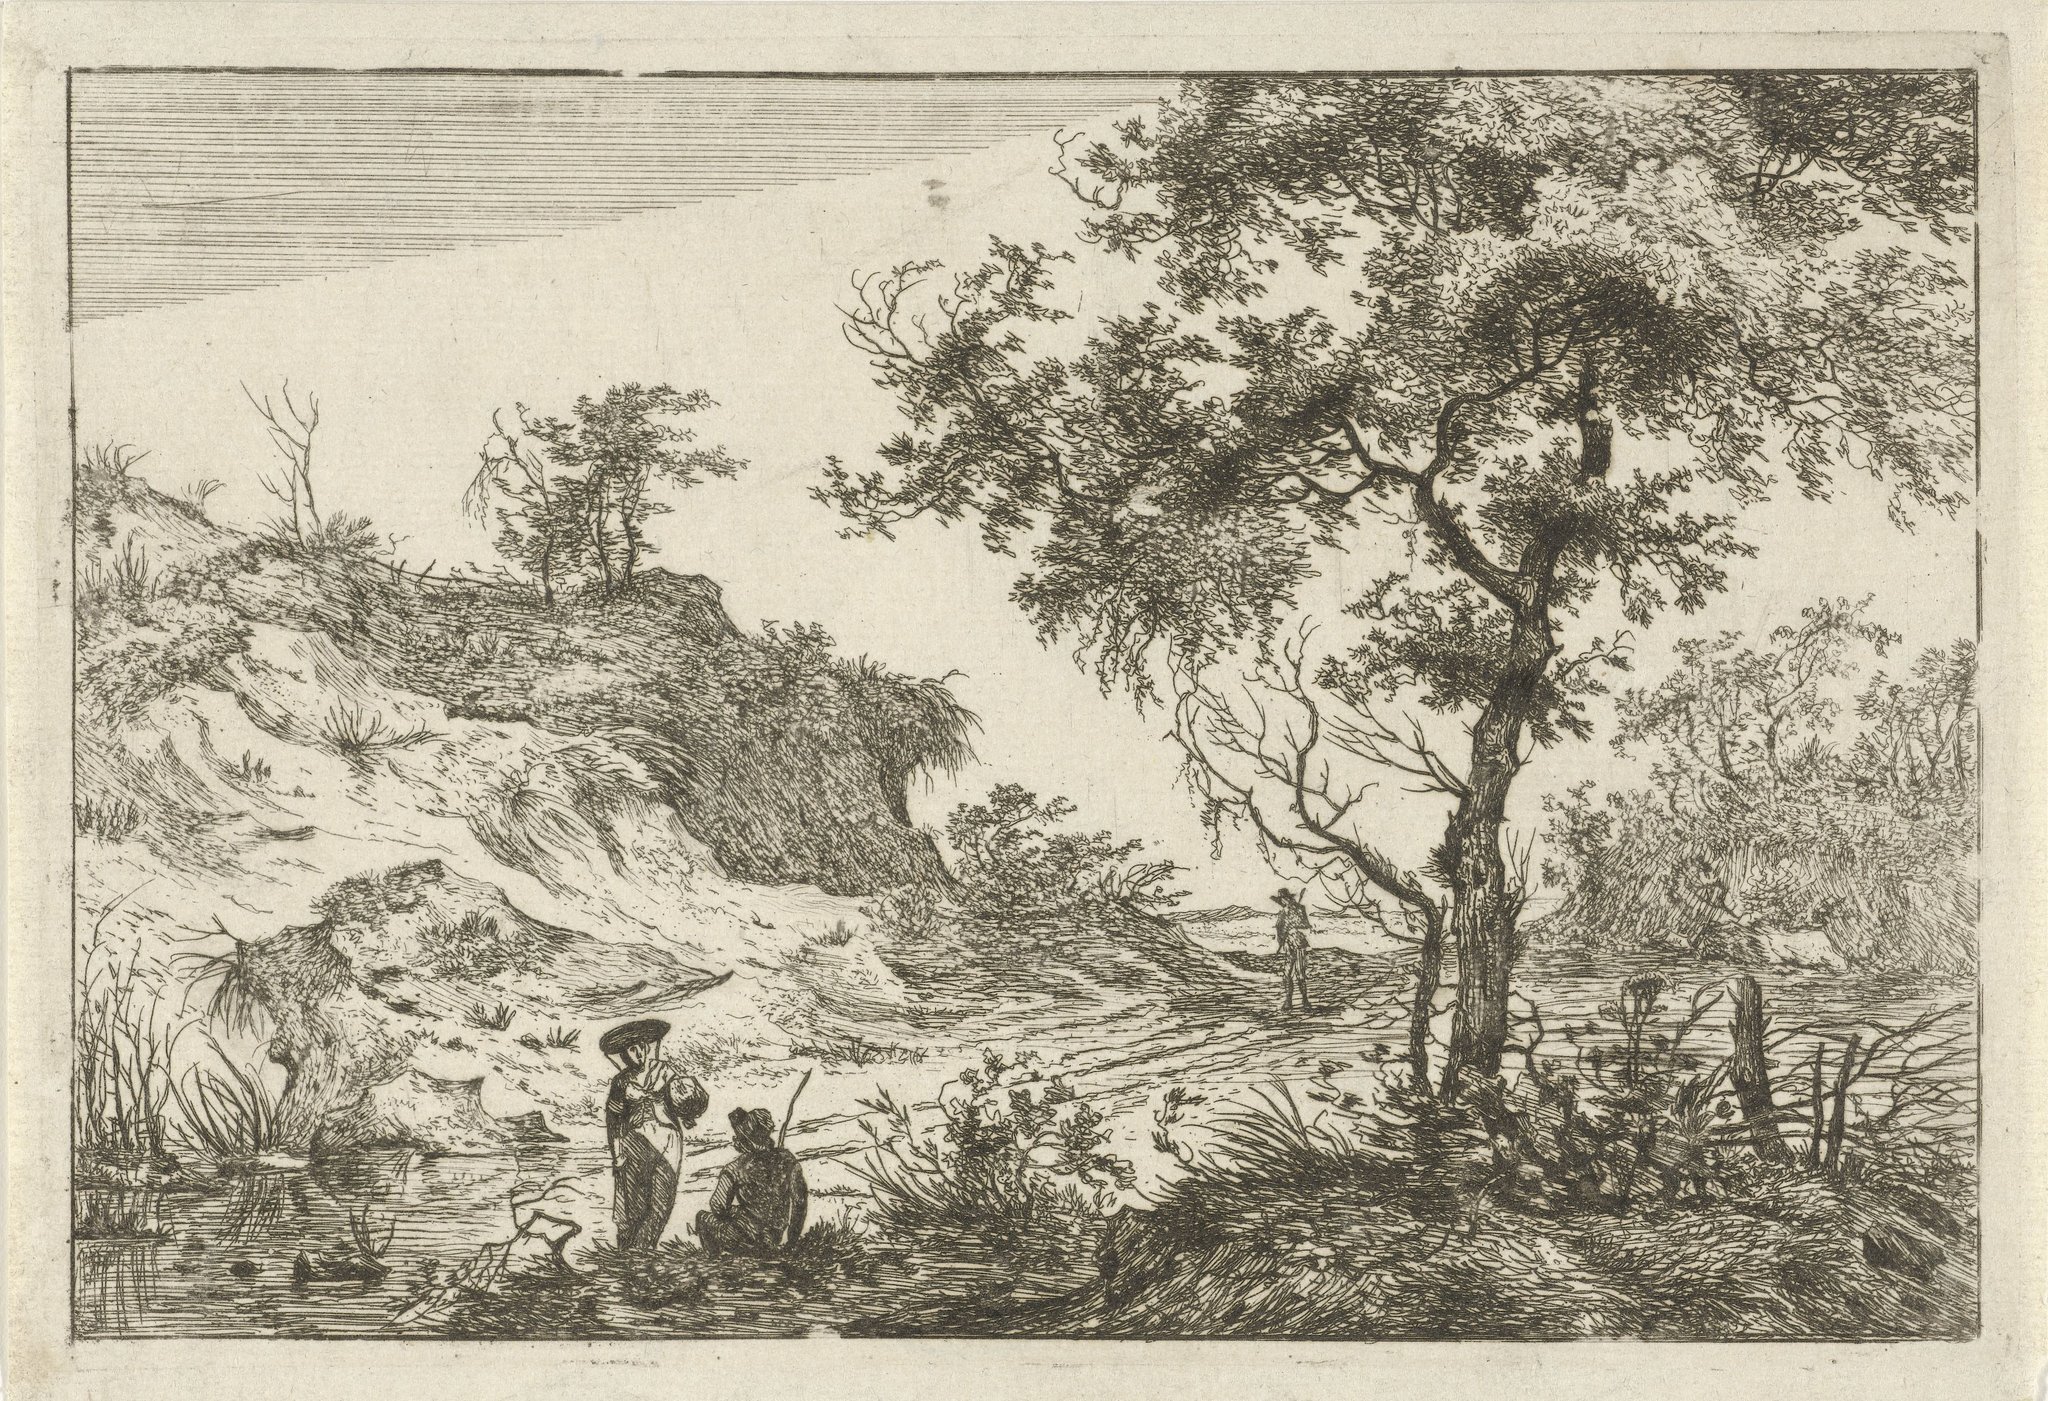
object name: print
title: Landschap met vrouw met hoed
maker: hermanus fock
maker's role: conservator, draughtsman, painter, print maker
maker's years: 1766-1822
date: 1781-1822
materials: paper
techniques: etching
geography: amsterdam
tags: dunes (sea not visible); in the dunes (+ landscape with figures, staffage)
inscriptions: collector's mark: Lugt 2228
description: Een duinlandschap met een grote boom. Op de voorgrond bij een plas staat een vrouw bij een zittende man. Op de achtergrond loopt een man op het zandpad.